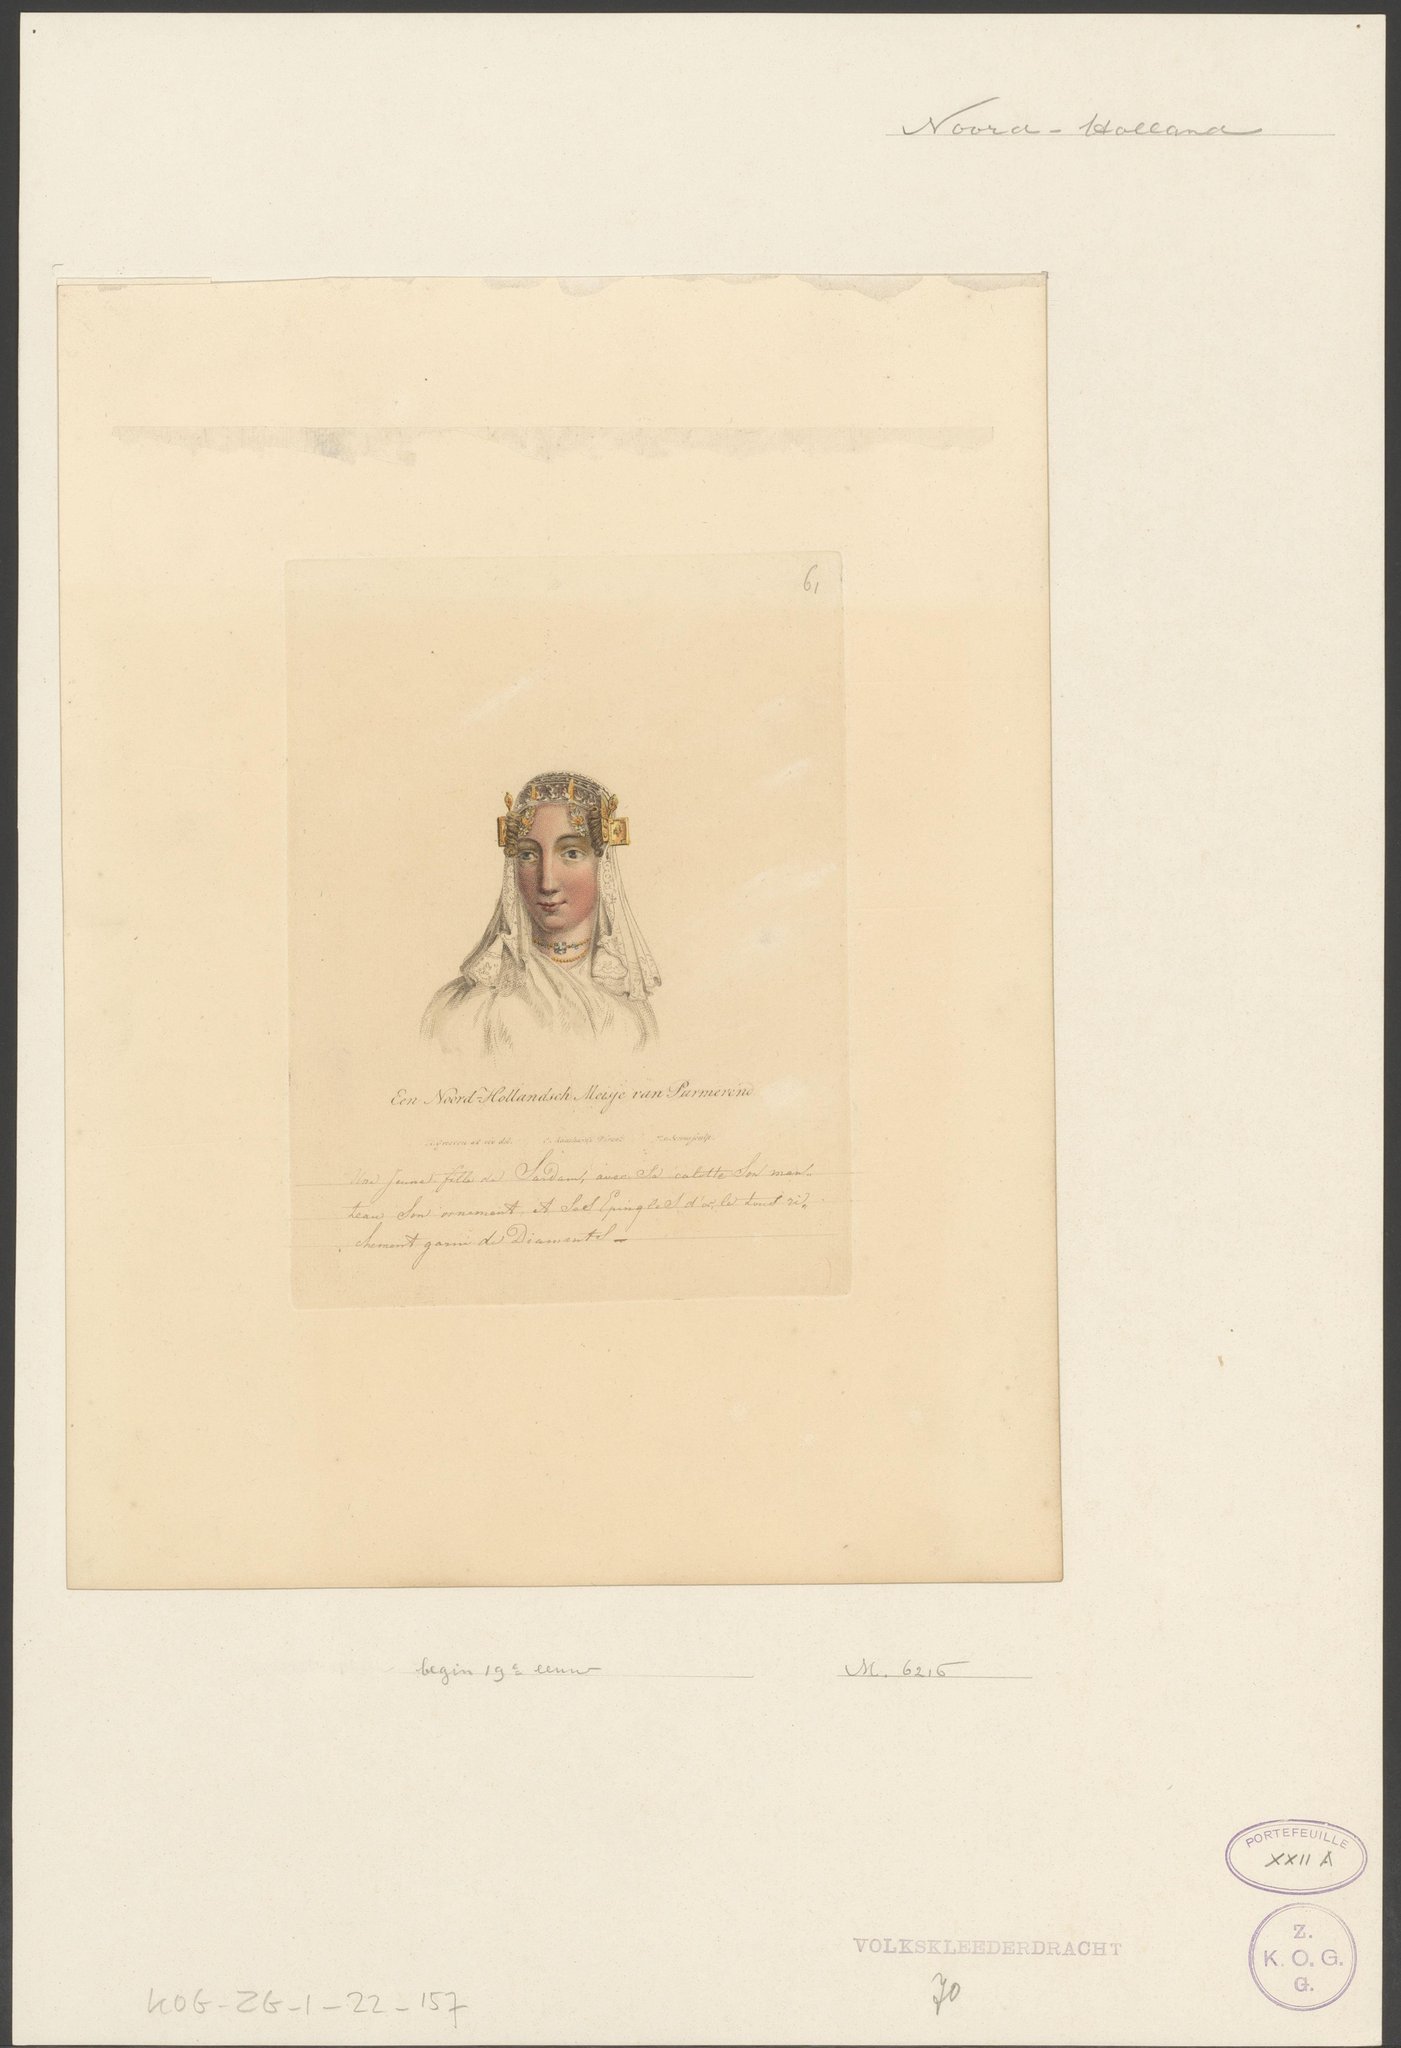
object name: print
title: Jonge vrouw uit Purmerend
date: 1816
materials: ink, paper, watercolor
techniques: etching, pen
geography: netherlands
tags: clothes, costume (+ women's clothes), folk costume, regional costume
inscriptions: collector's mark: Lugt 1641, collector's mark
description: Oorspronkelijk gebruikt als illustratie in: G. Johnson, Karakterschetsen : zeden en gewoonten van Nederlandsche mannen en vrouwen, in het jaar 1816 bijeenverzameld op eene reize door het Koningrijk der Nederlanden. E. Maaskamp: Amsterdam, [1816], p. 64/65. Daarna heruitgegeven in: Maaskamp, Evert. Tableau des principales vues des palais et édifices : représentations et des coutumes et usages, dans les provinces septentrionales du Royaume des Pays-Bas. Amsterdam, 1824.